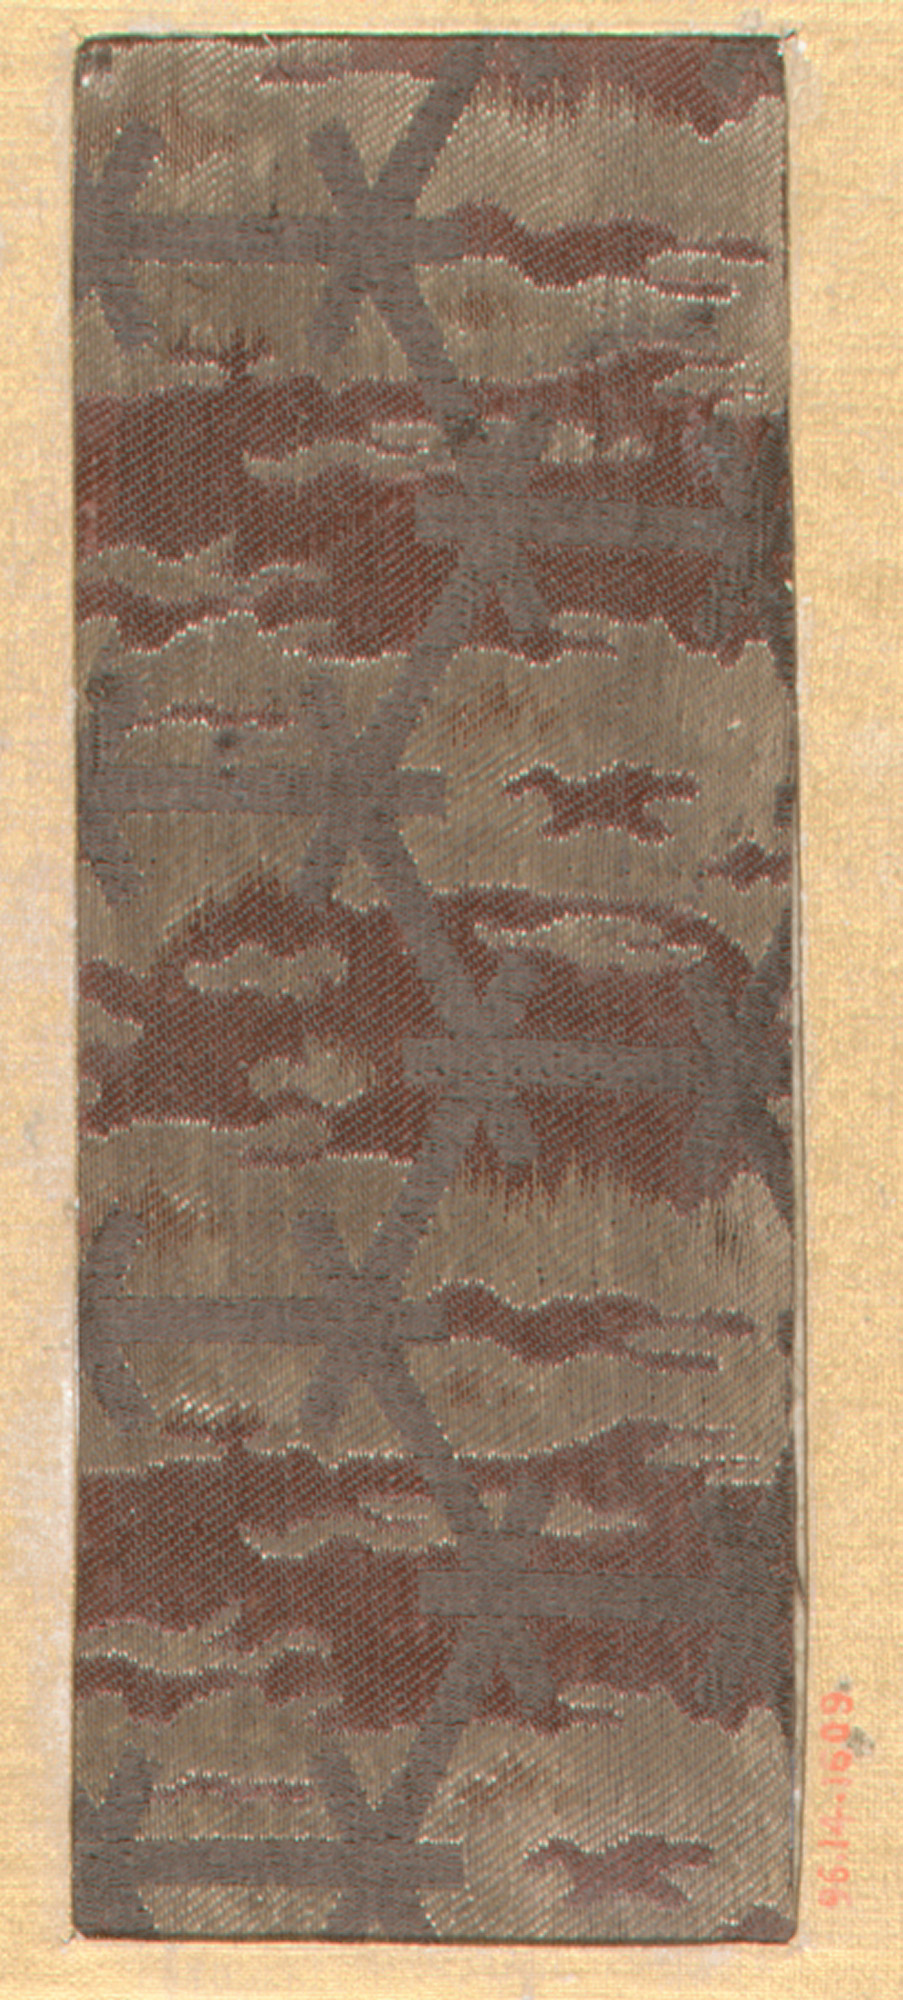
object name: piece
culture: japanese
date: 1701-1900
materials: silk